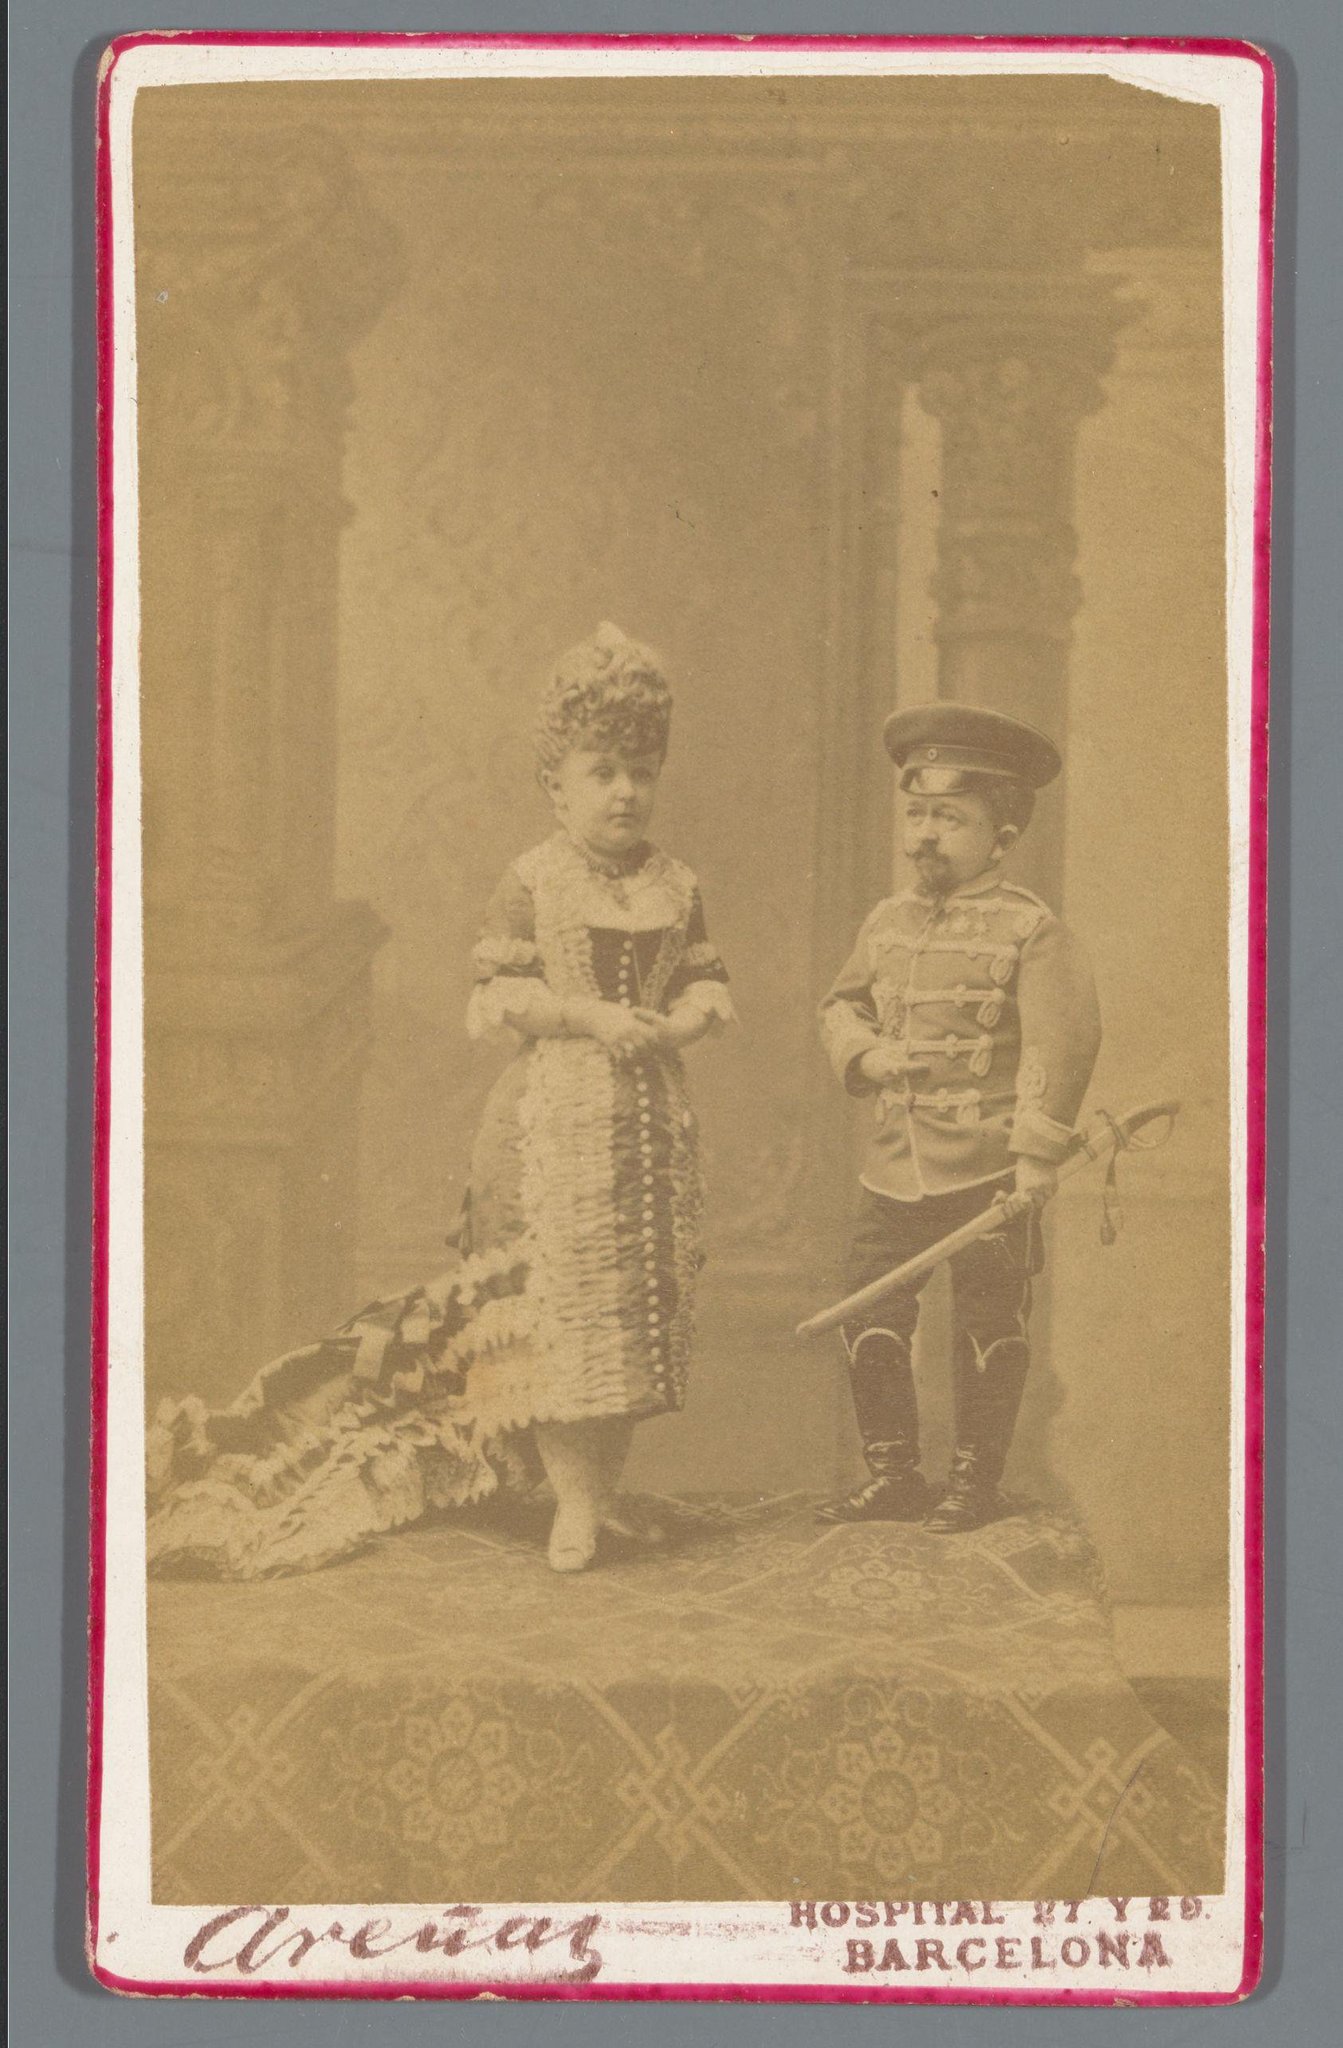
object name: carte de visite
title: Portret van een onbekende kleine man en een onbekende kleine vrouw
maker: rafael areñas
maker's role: fotograaf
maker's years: 1846-1891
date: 1850-1900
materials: cardboard, paper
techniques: albumen print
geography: barcelona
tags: adult woman, little people, adult man, historical persons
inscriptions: inscription: ‘RAFAEL AREÑAS, FOTÓGRAFO/ DE S. S. M. M. LOS REYES DE ESPAÑA Y PORTUGAL./ Gaballero de la Real Urden de Isabel la Católica,/ BURDEOS AMSTERDAM PARIS VILLANEUVA [...] y Miembro de la Sociedad Francesa de Fotografia./ HOSPITAL, 27 Y 29, BARCELONA.’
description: Portret van een onbekende man en een onbekende vrouw (kleine mensen).